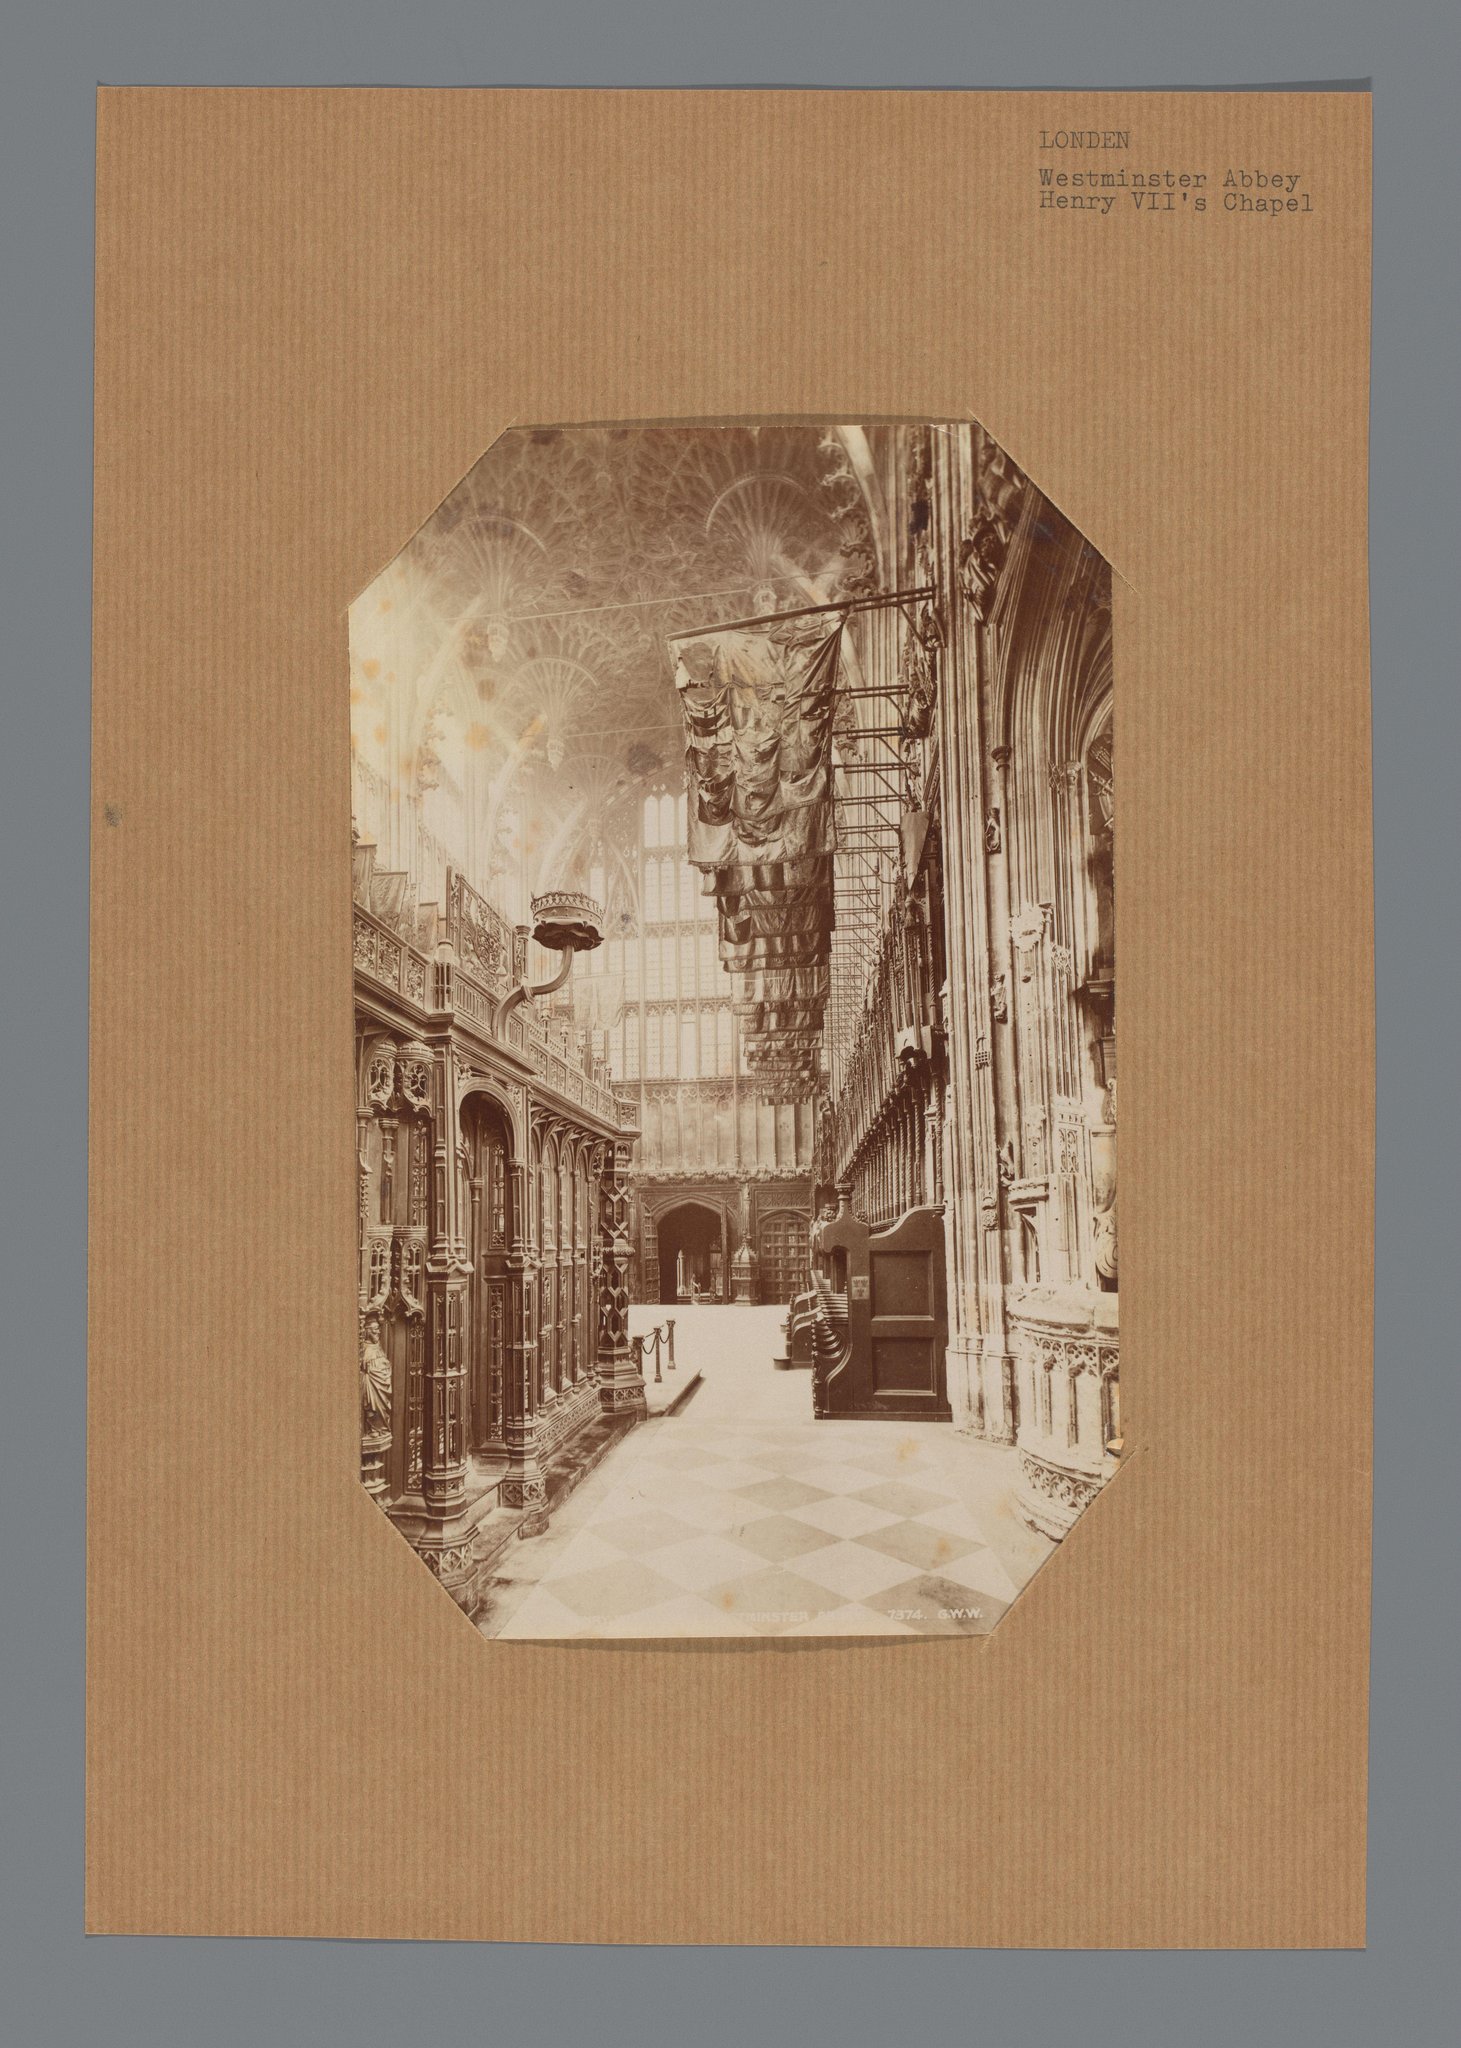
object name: photograph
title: Londen. Westminster Abbey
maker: Anonymous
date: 1850-1900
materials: photographic support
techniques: albumen print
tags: westminster abbey